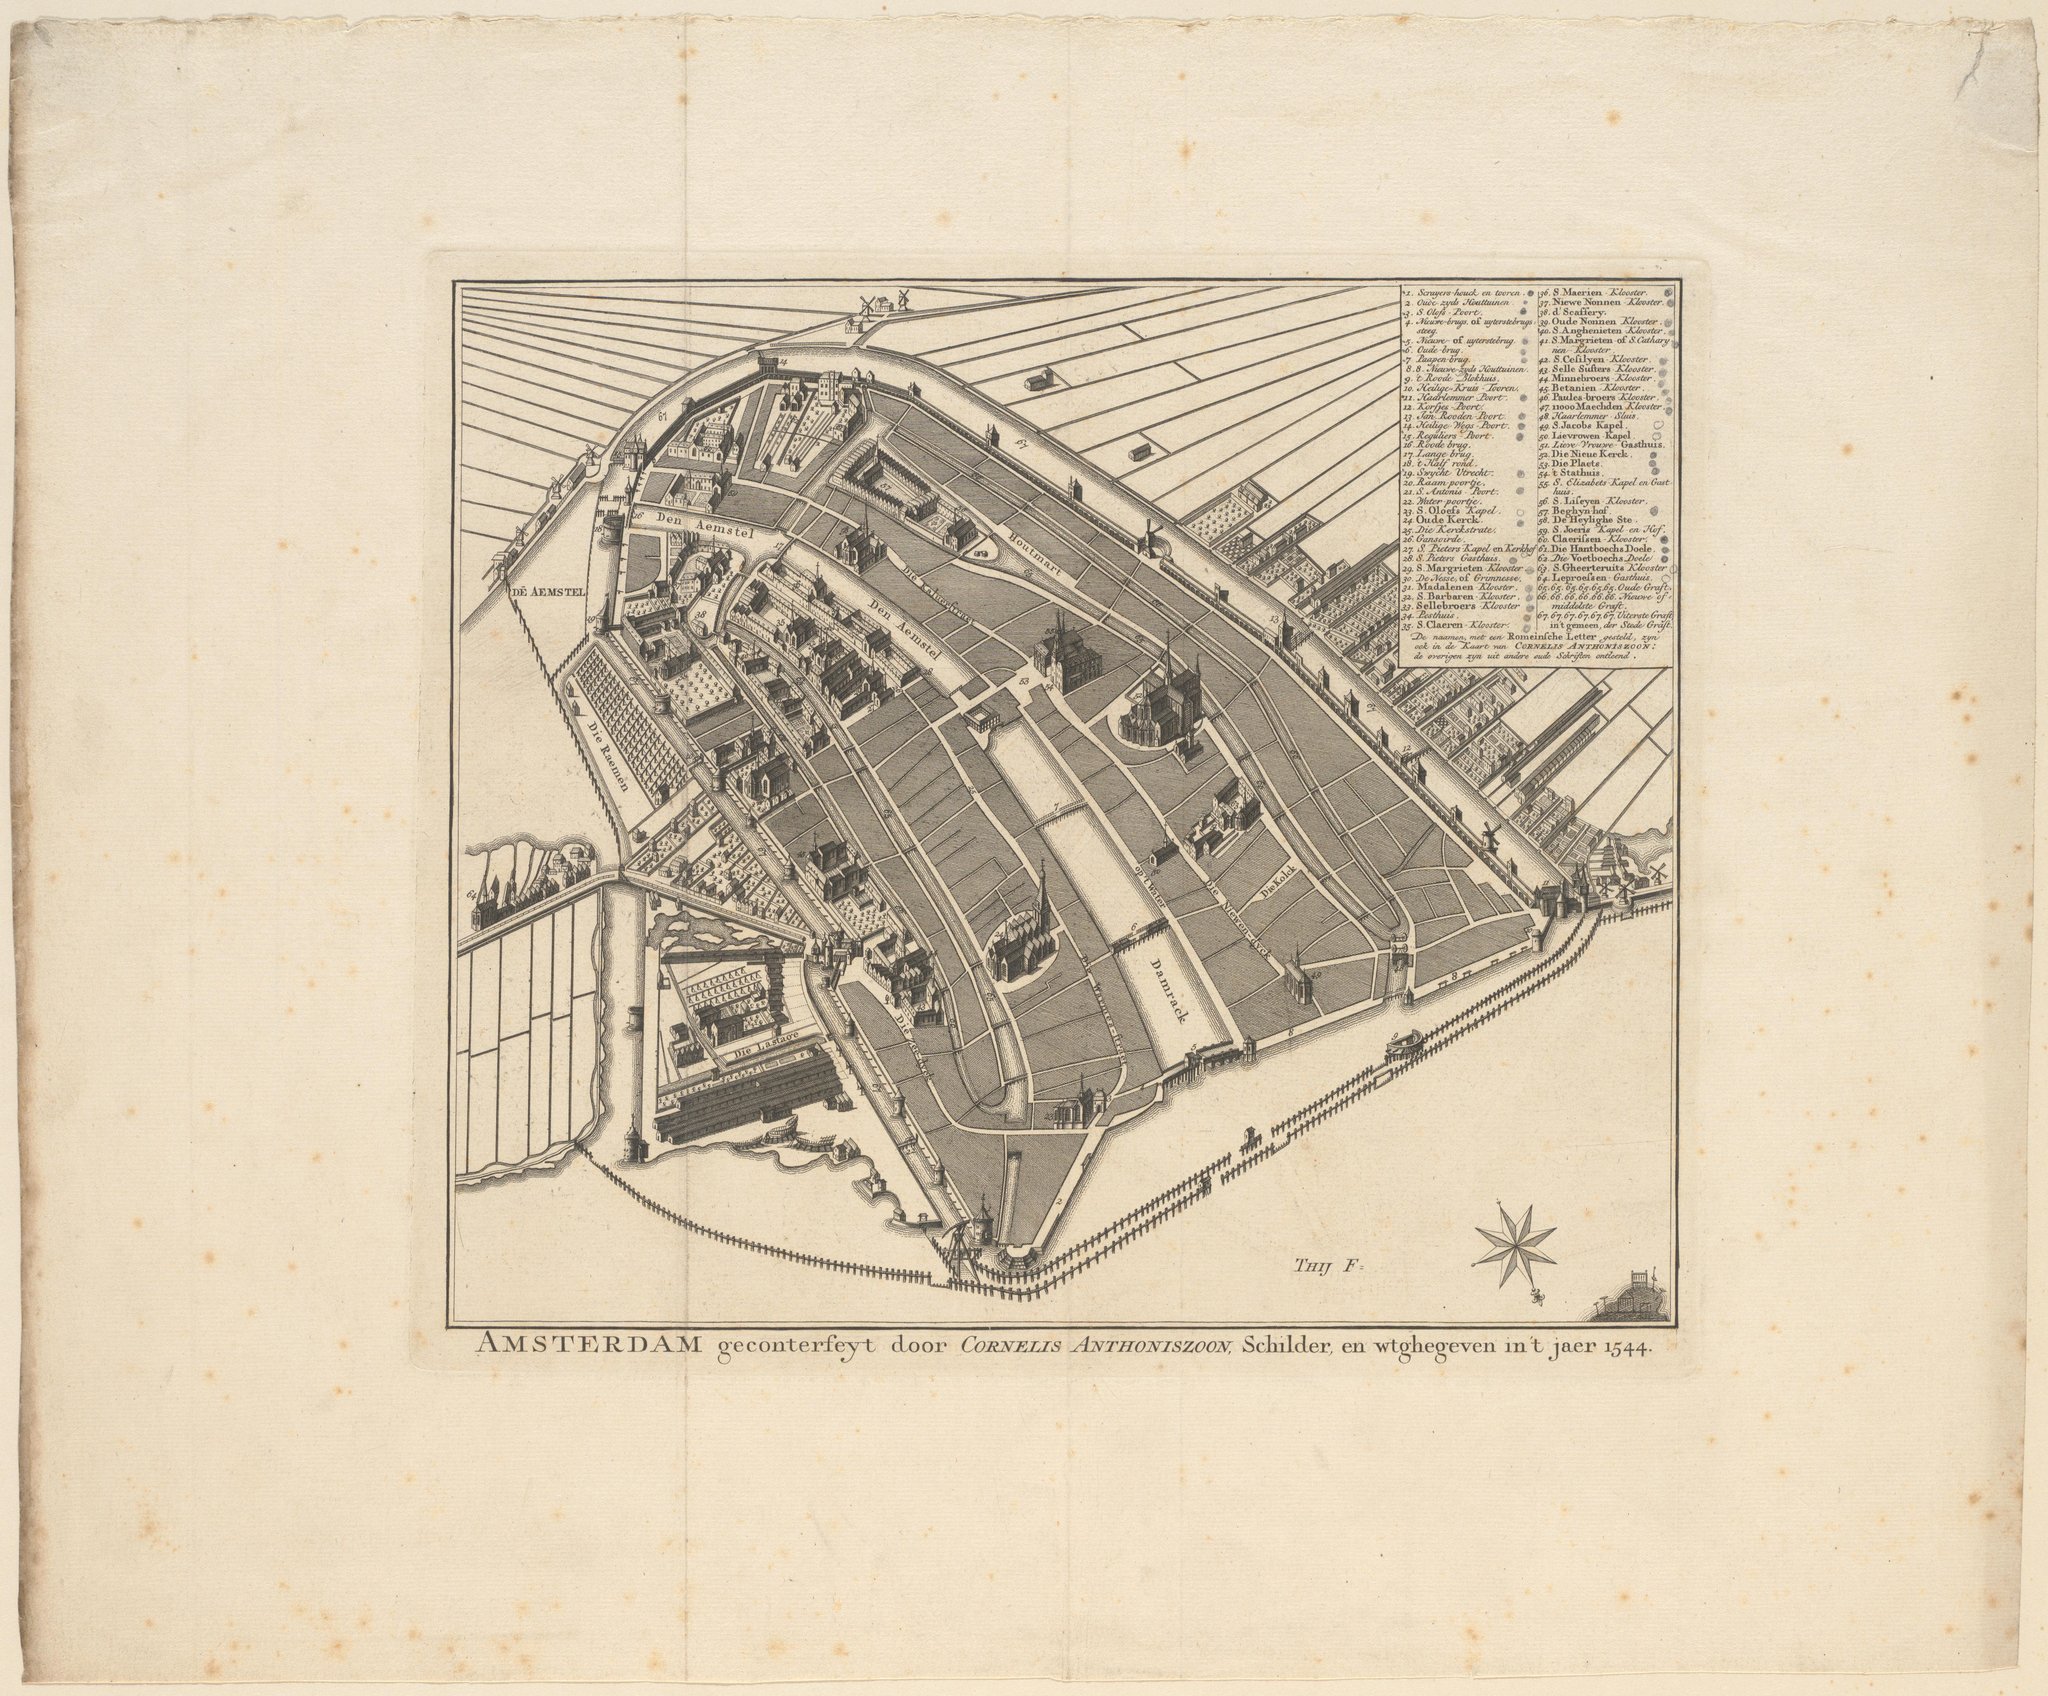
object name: map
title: Plattegrond van Amsterdam, 1544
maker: Anonymous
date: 1760-1799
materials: paper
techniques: engraving, etching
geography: amsterdam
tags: maps of cities, amsterdam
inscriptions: collector's mark: Lugt 1641b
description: Kopie naar een prent uit: Wagenaar, Jan. Amsterdam, in zyne opkomst, aanwas, geschiedenissen (…). Amsterdam: Isaak Tirion, 1760, dl. 1.